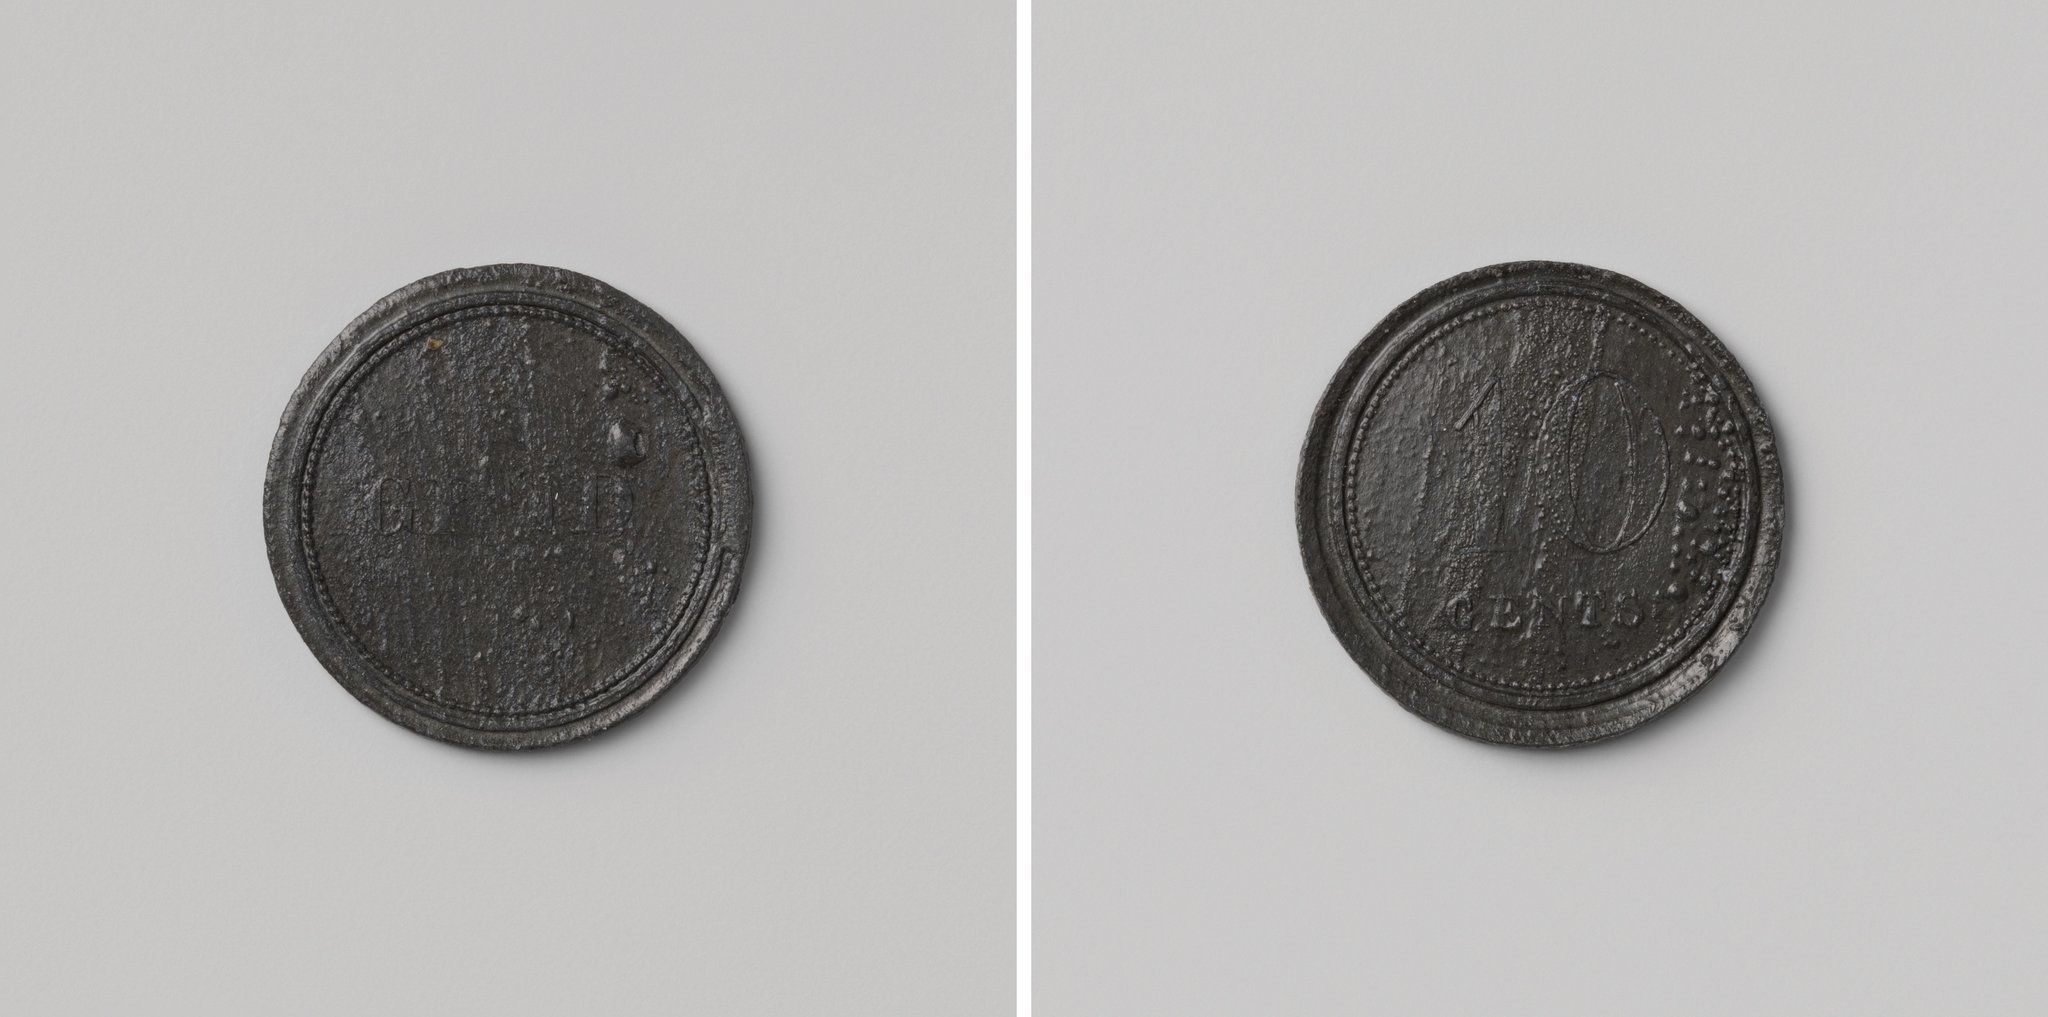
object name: monetary token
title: Strafgevangenis te Gent, huismunt ter waarde van tien cents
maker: Anonymous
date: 1826-1833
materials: zinc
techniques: striking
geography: brussels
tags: ghent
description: Zinken betaalpenning. Voorzijde: opschrift. Keerzijde: waardeaanduiding